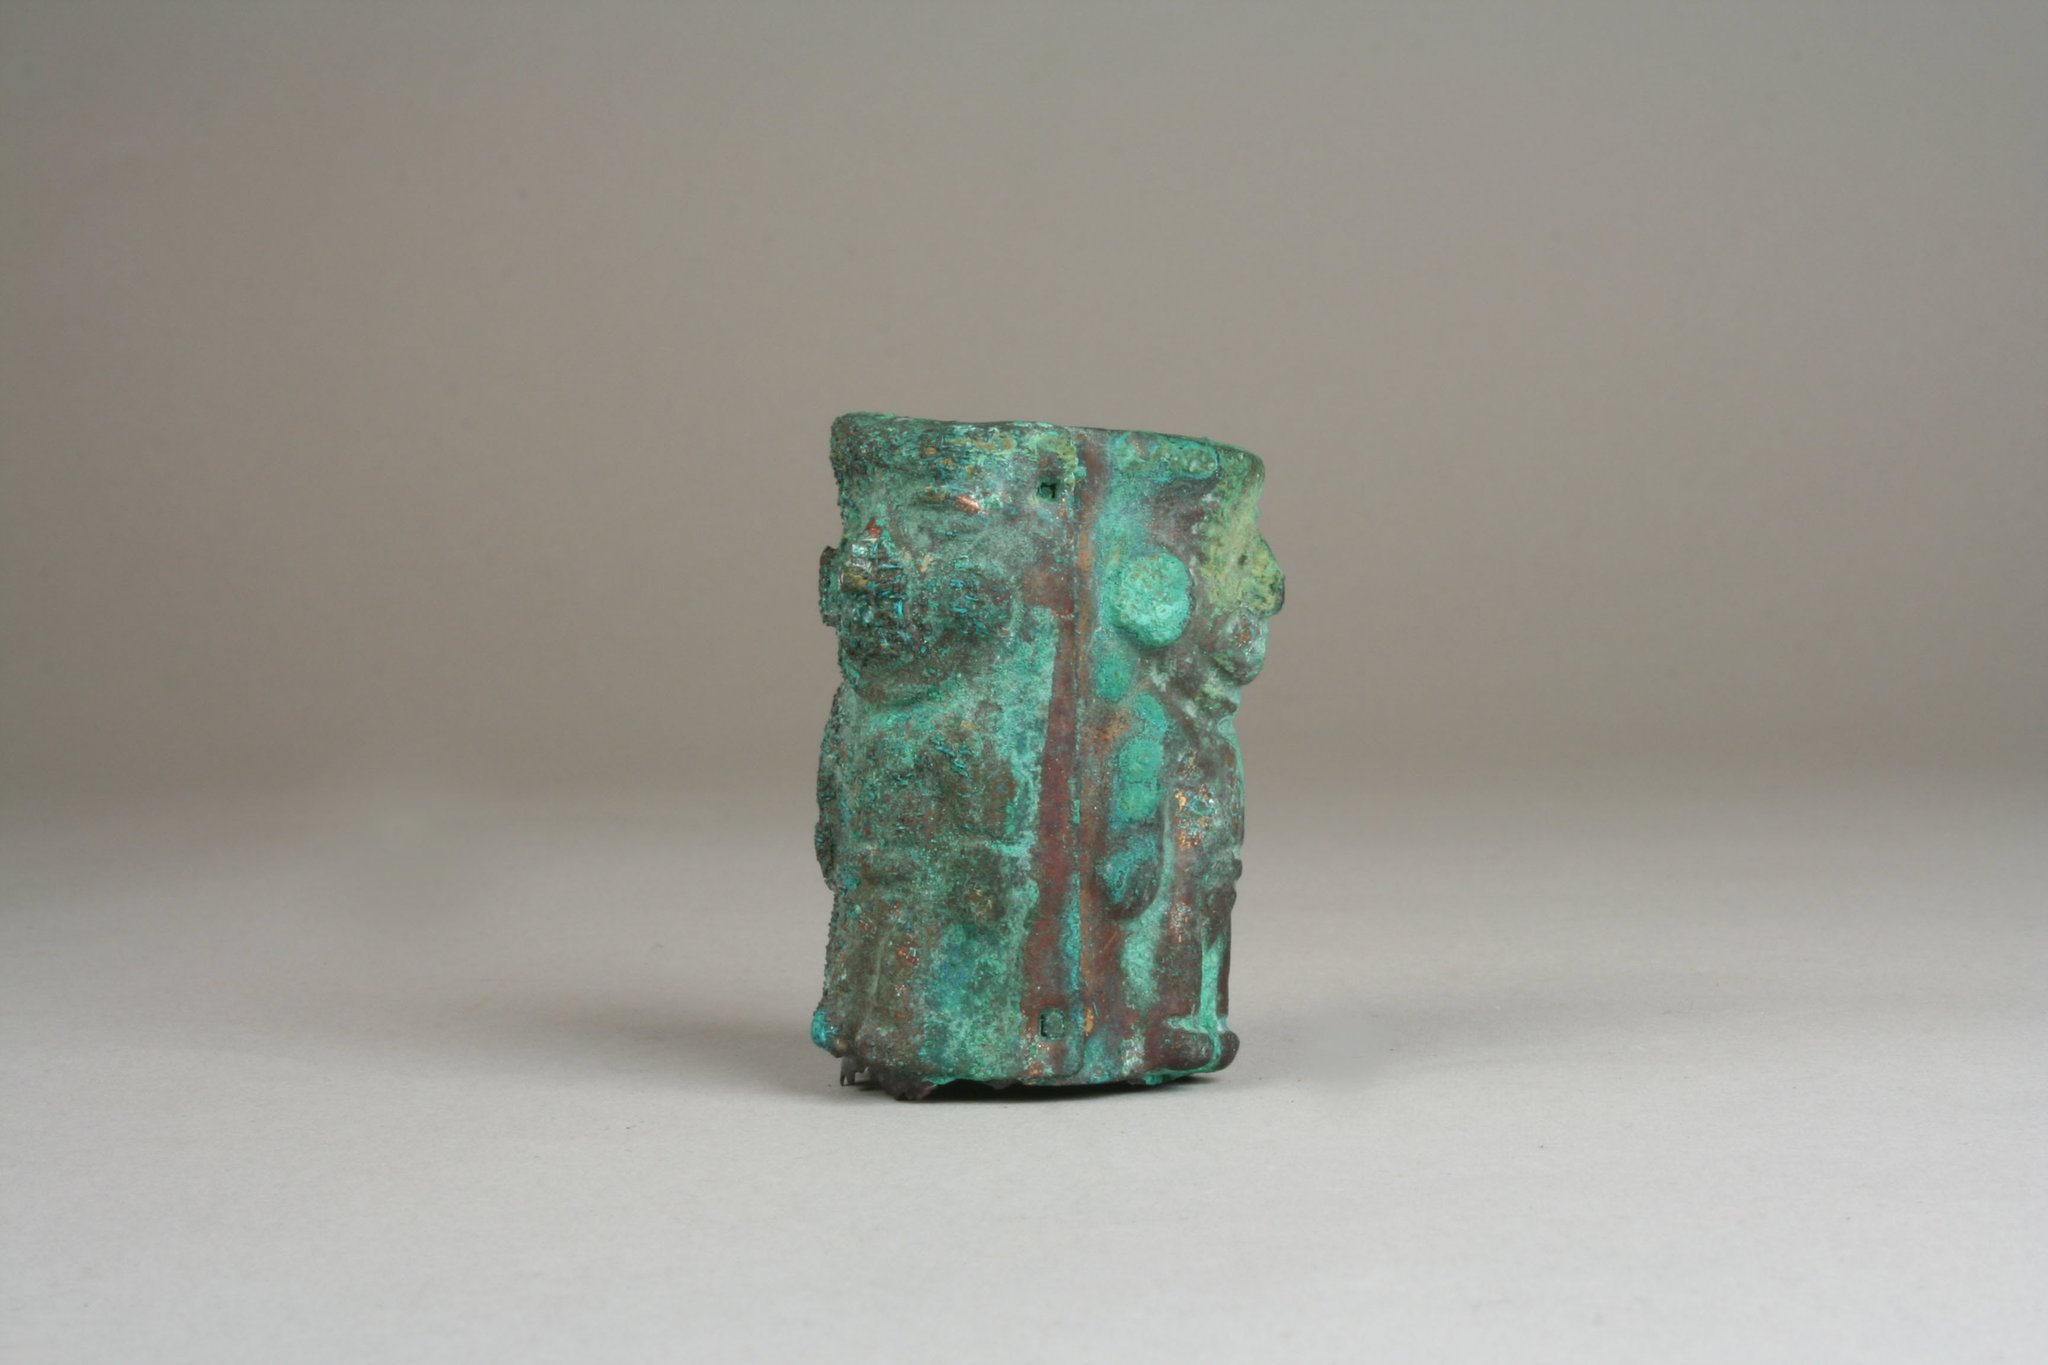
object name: staff head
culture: moche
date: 501-700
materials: gilt copper, metal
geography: peru